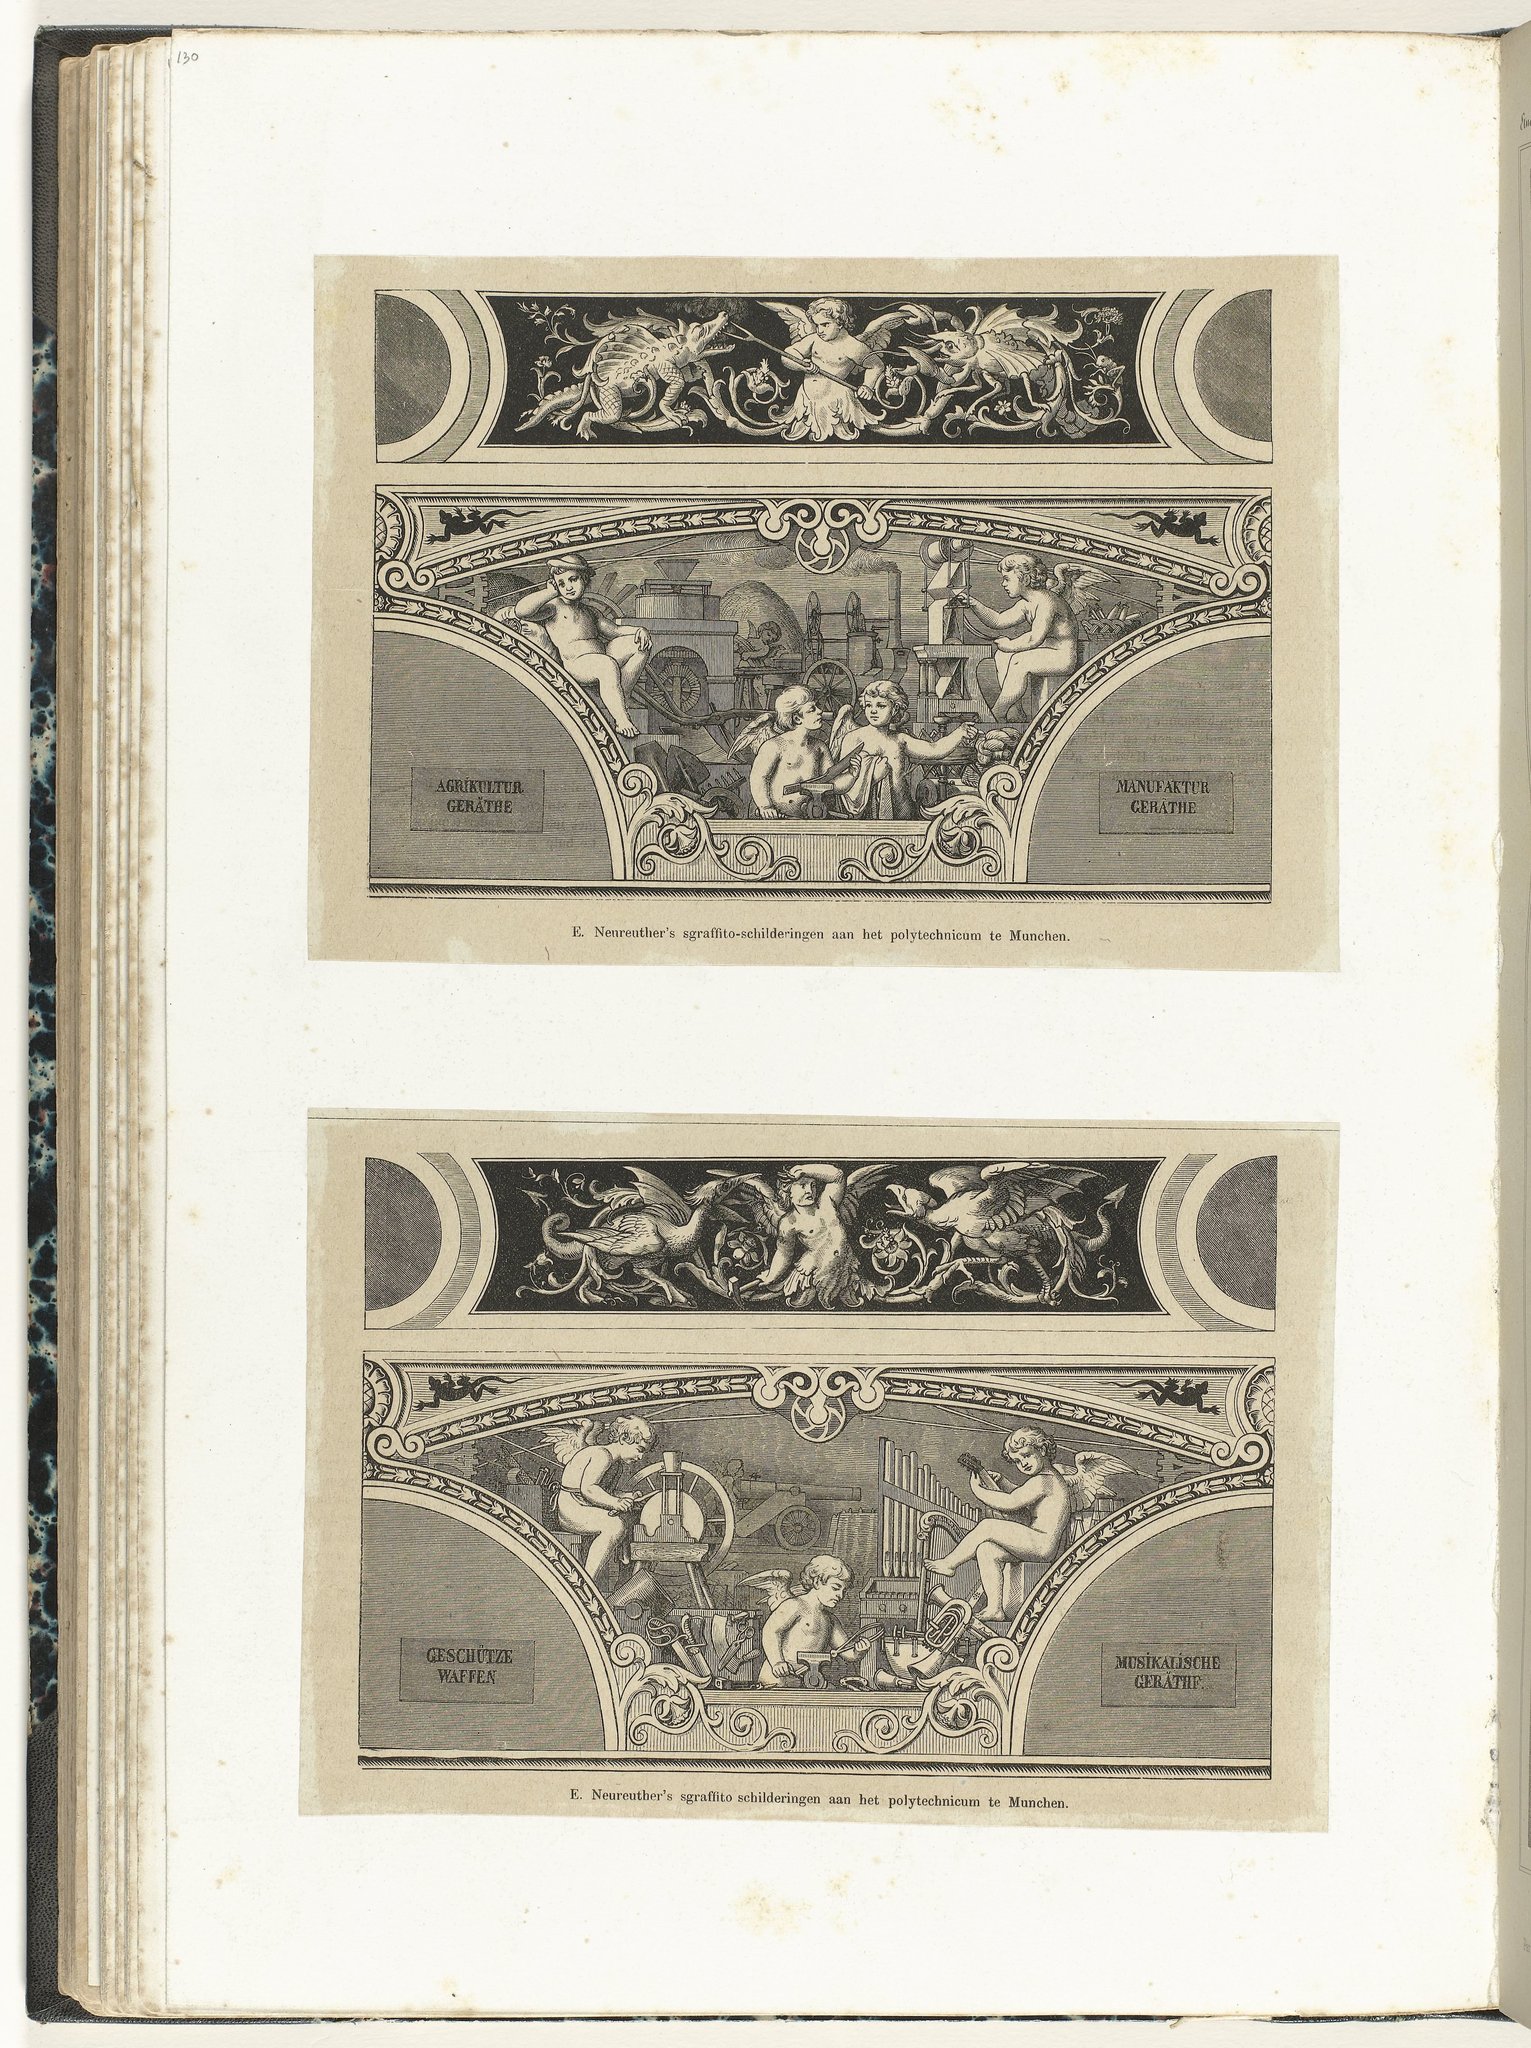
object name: print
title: Twee prenten met werkende putti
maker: Anonymous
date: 1866-1900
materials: paper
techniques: engraving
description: Bovenaan een fries en een omlijsting met vijf putti die landbouwgereedschap en textiel maken, onderaan een fries en een omlijsting met vier putti die wapens en muziekinstrumenten maken. Onder beide prenten staat: E. Neureuther's sgraffito(-)schilderingen aan het polytechnicum te Munchen.